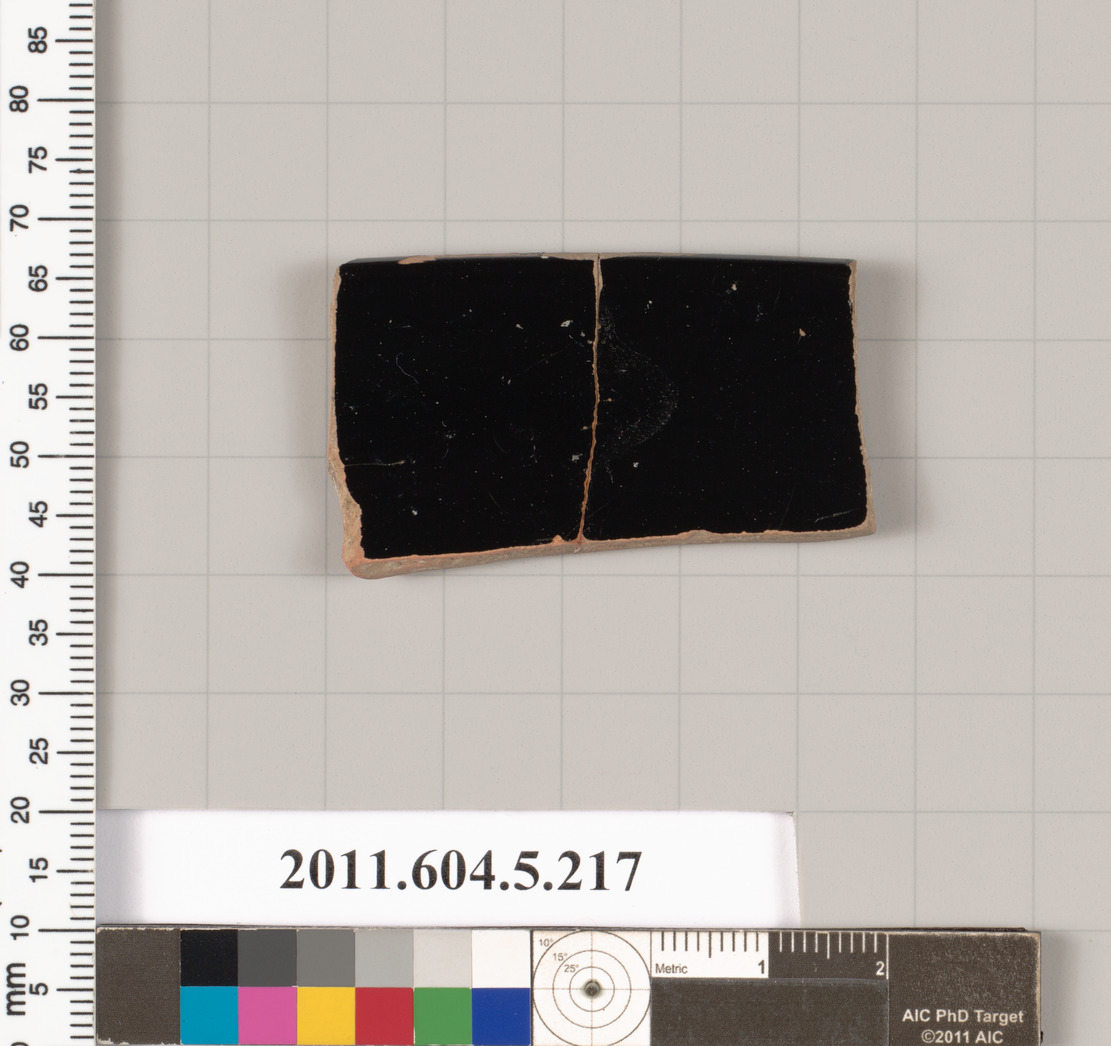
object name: kylix fragment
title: Terracotta rim fragment of a kylix (drinking cup)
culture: greek, attic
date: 600-401 BCE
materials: terracotta